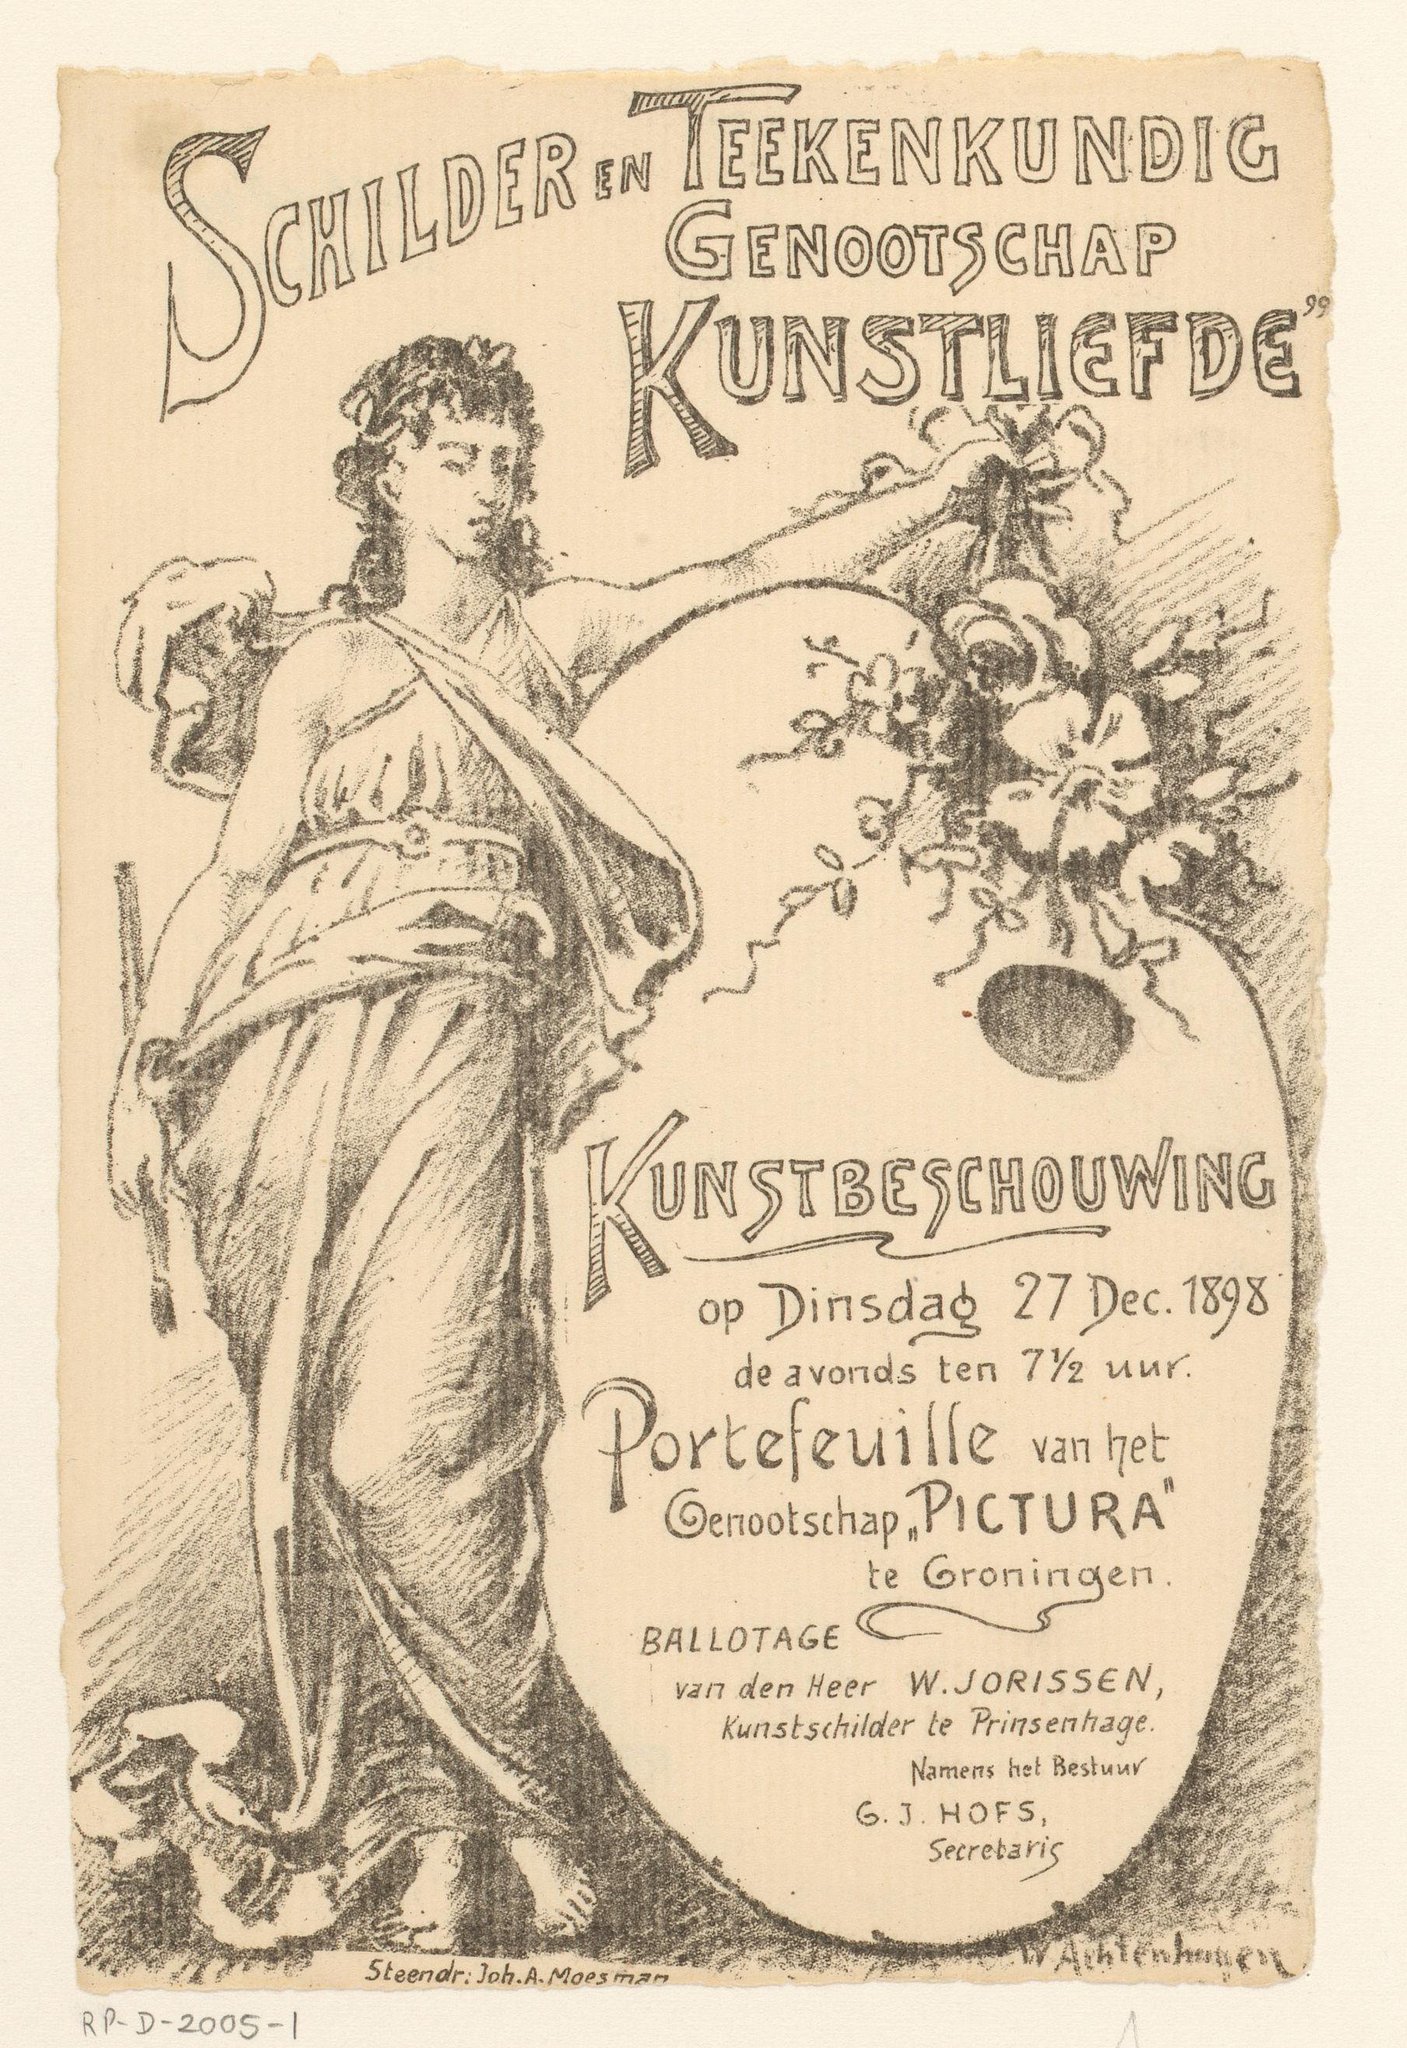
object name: print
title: Uitnodiging van Schilder- en Teekenkundig Genootschap "Kunstliefde" voor een kunstbeschouwing, 27 december 1898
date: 1812-1898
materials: paper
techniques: lithograph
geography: netherlands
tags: criticizing and discussing art, art criticism, circle, club of artists, collecting and exhibiting products of the fine arts, 'pictura', symbolic representations, allegories and emblems ~ painting; 'pittura' (ripa)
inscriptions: collector's mark: Lugt 2228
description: Pictura. Uitnodiging van Schilder- en Teekenkundig Genootschap "Kunstliefde" voor een kunstbeschouwing op 27 december 1898 van de portefeuille van het Genootschap "Pictura".